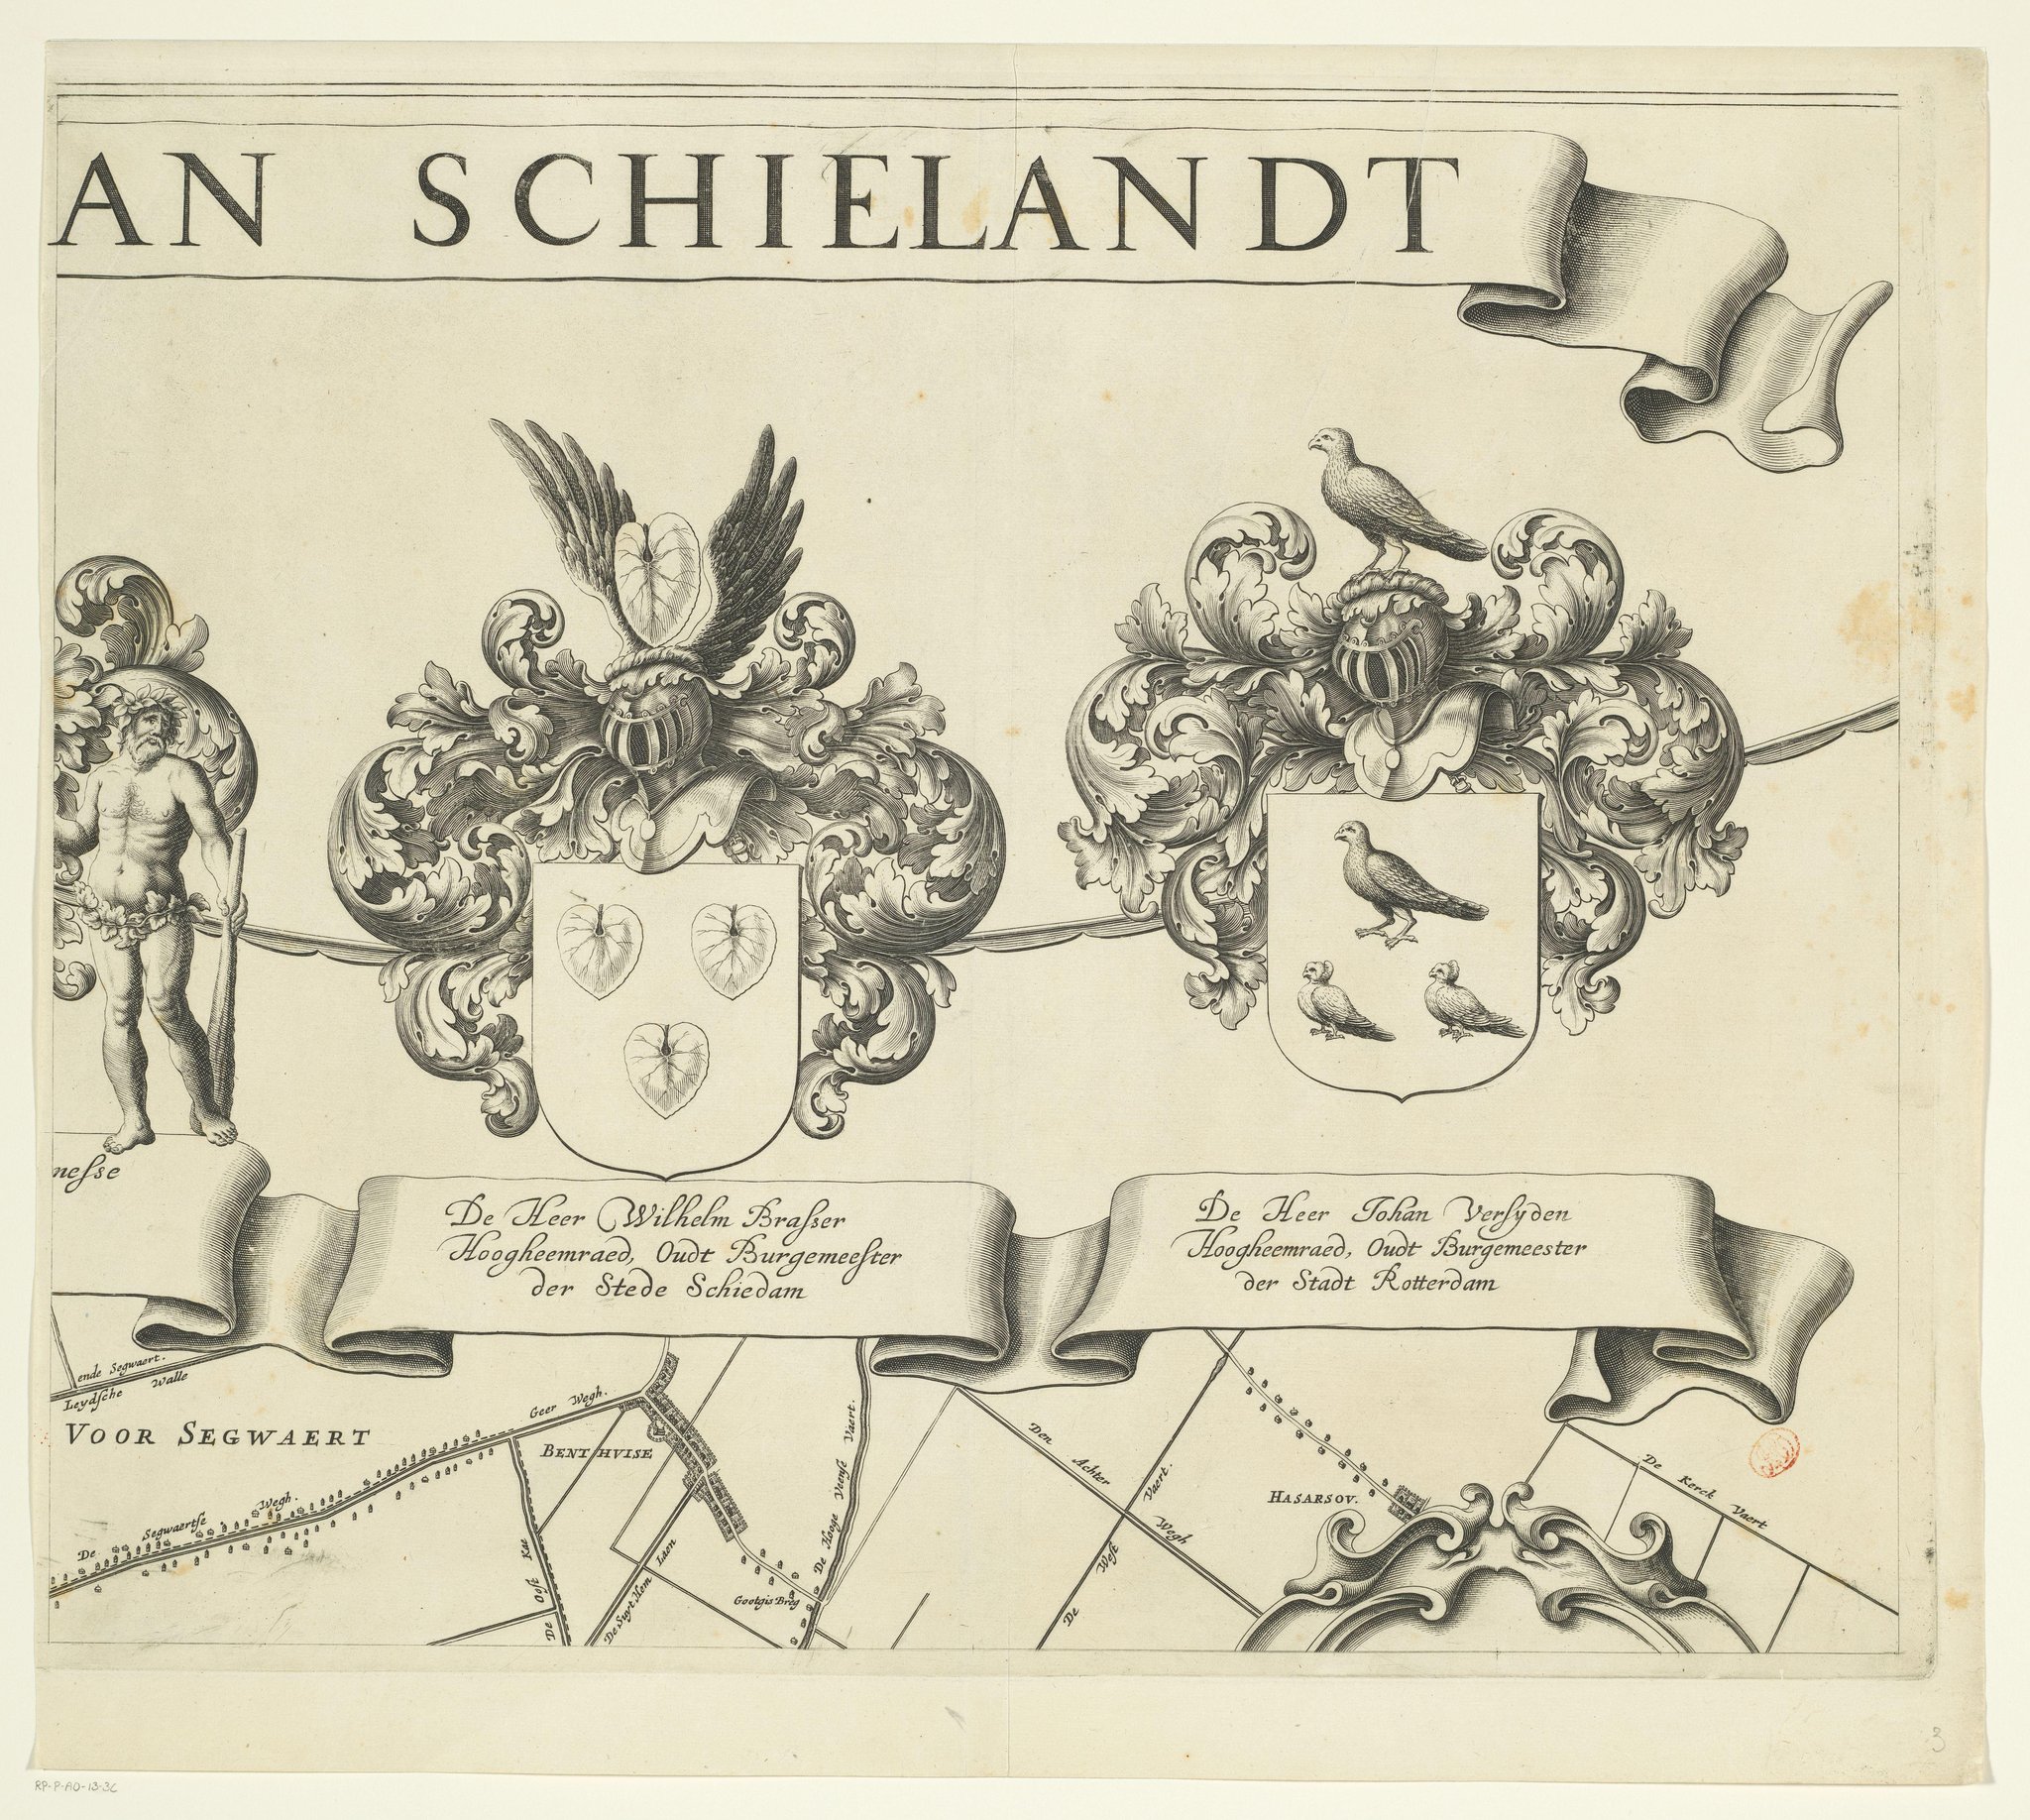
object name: map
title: Het Hooge Heemraedtschap van Schielandt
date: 1684-1718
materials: paper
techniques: engraving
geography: rotterdam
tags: maps of separate countries or regions, armorial bearing, heraldry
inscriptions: collector's mark: Lugt 2228, collector's mark: Lugt 195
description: Derde deel van een kaart van het Hoogheemraadschap van Schieland bestaande uit negen delen.